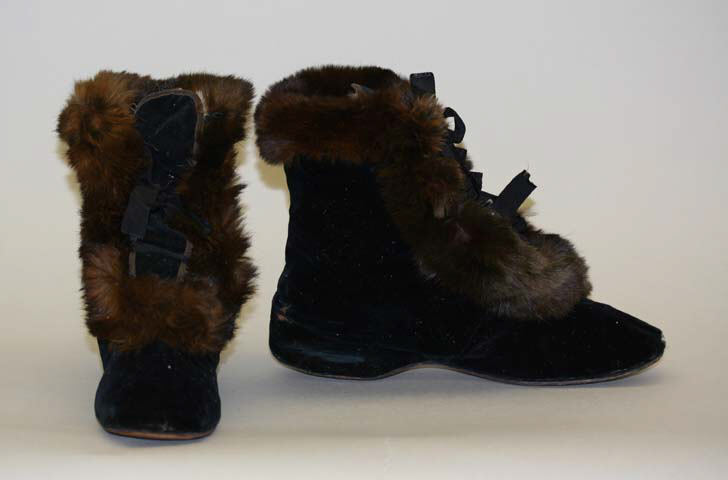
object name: overboots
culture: american or european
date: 1870-1879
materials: cotton, fur